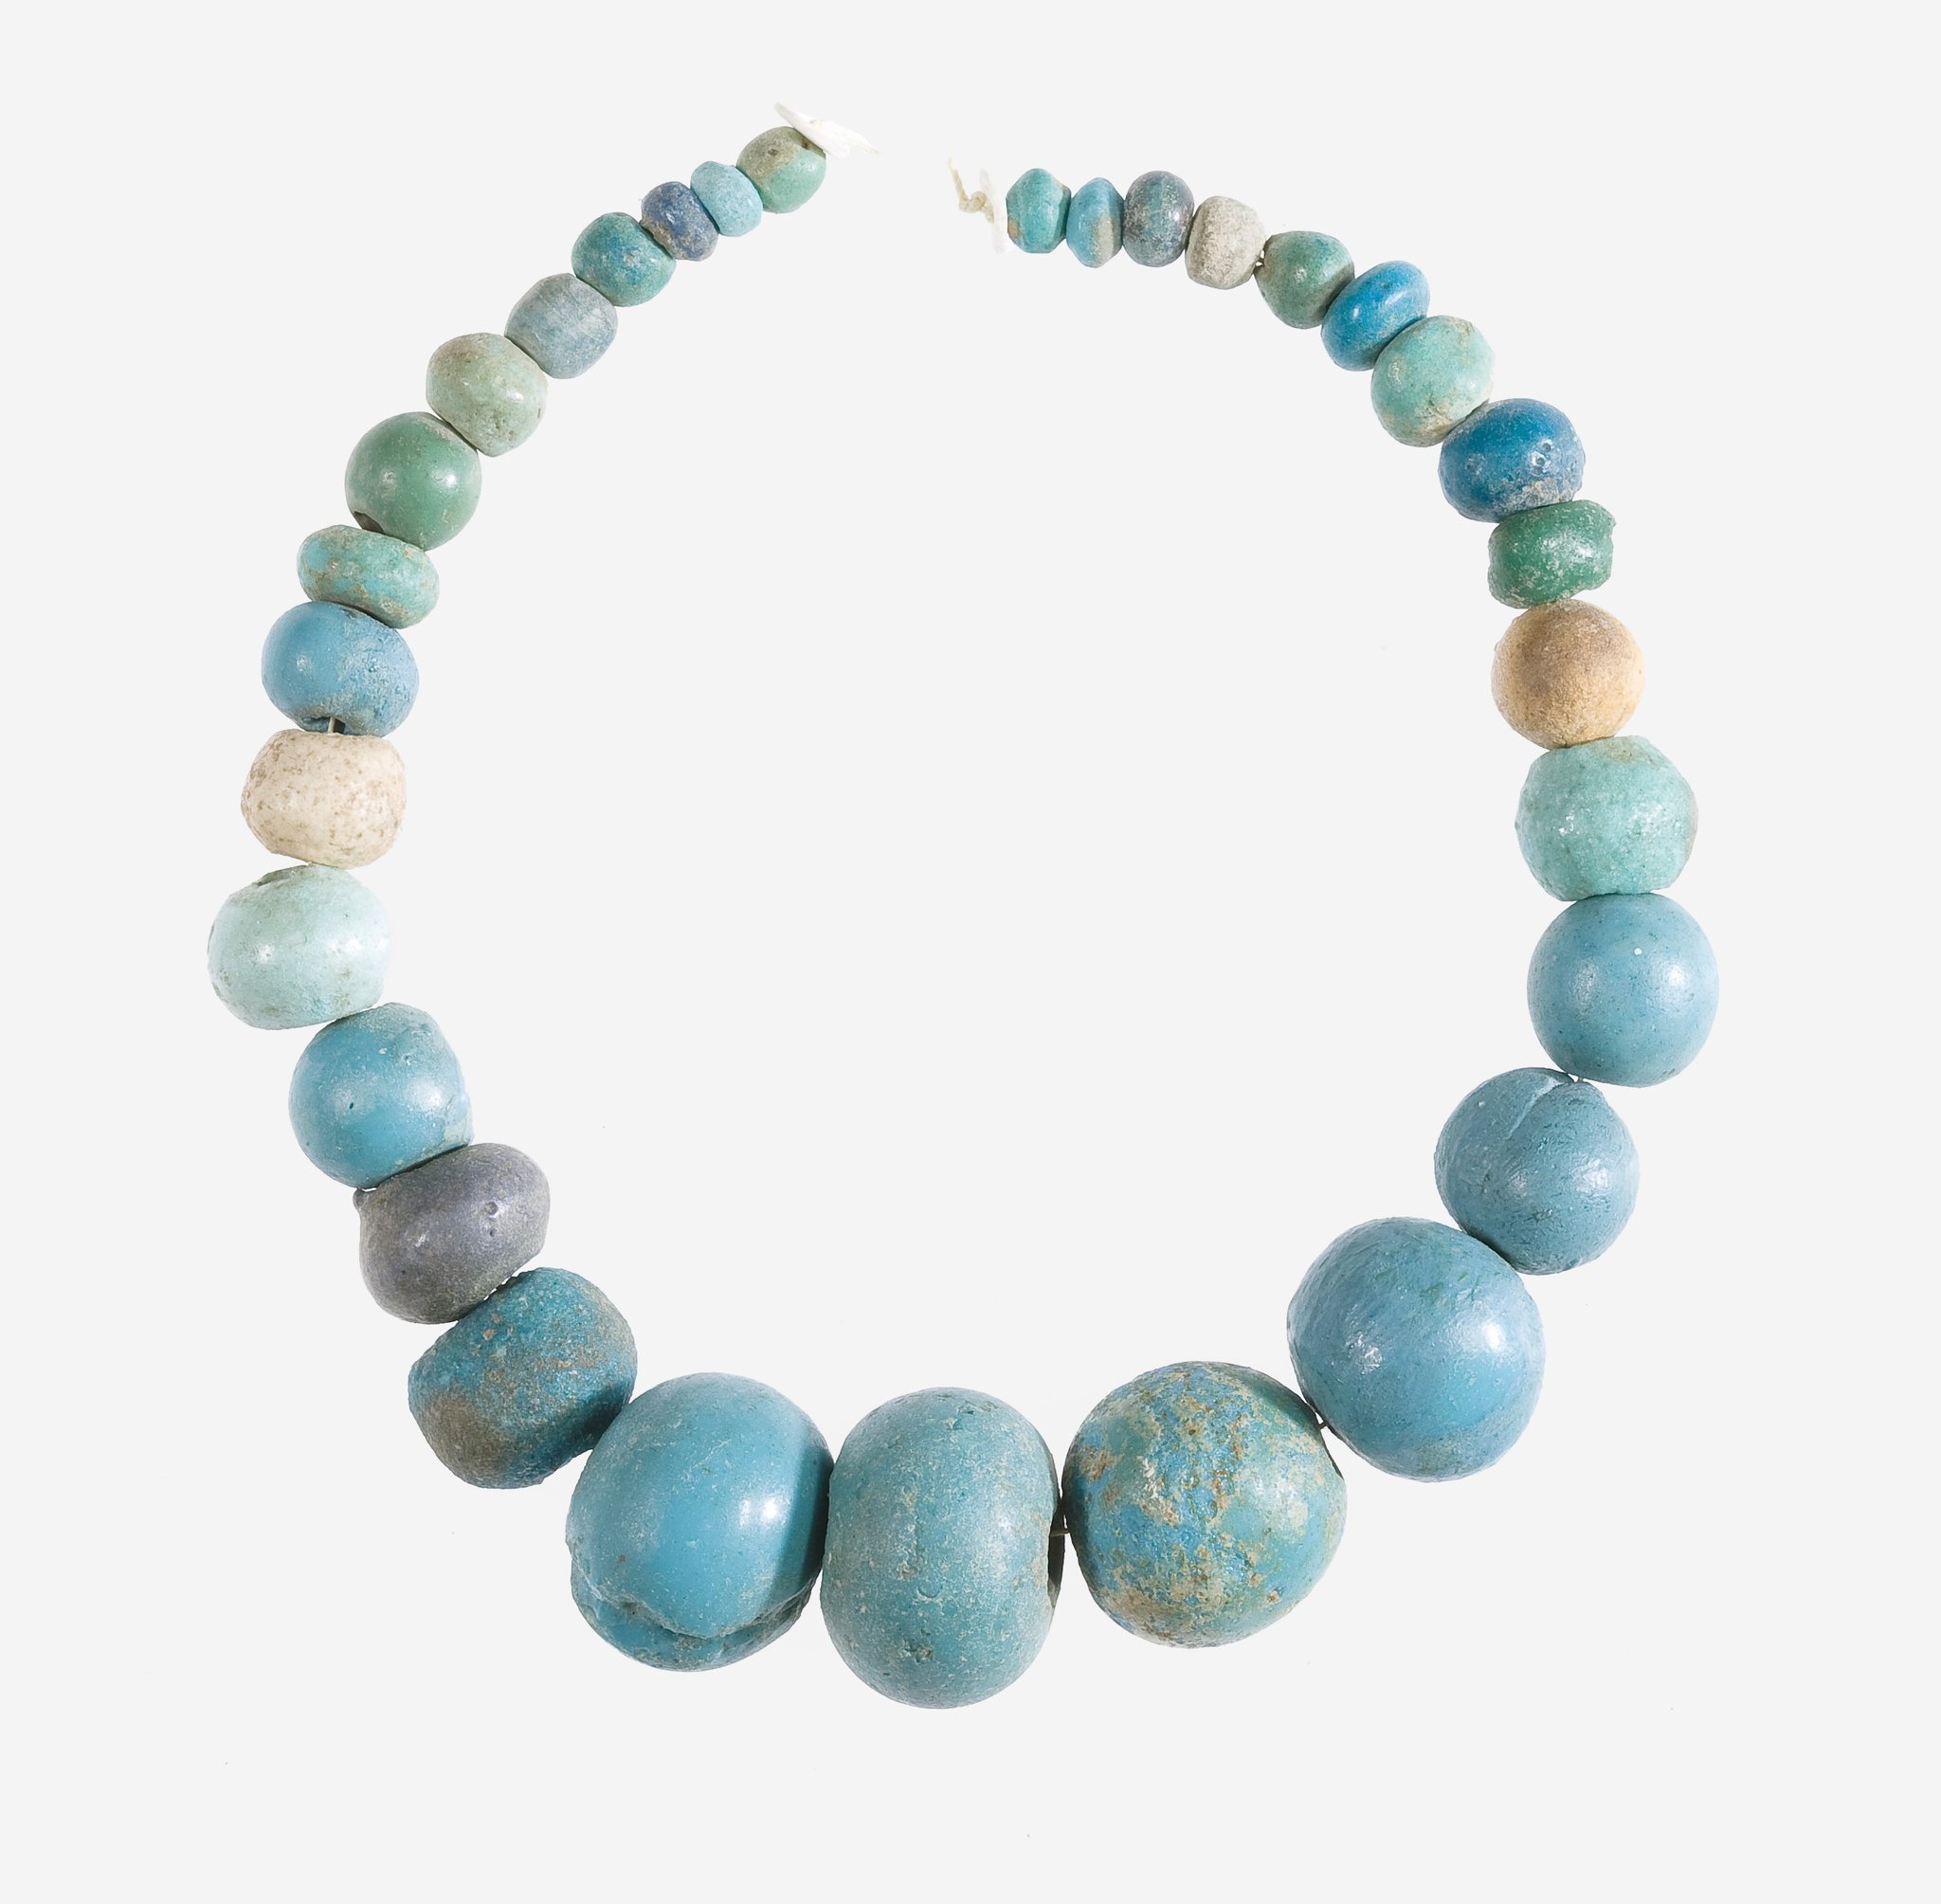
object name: bead, string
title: String of Ball Beads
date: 1390-1352 BCE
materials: faience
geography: egypt